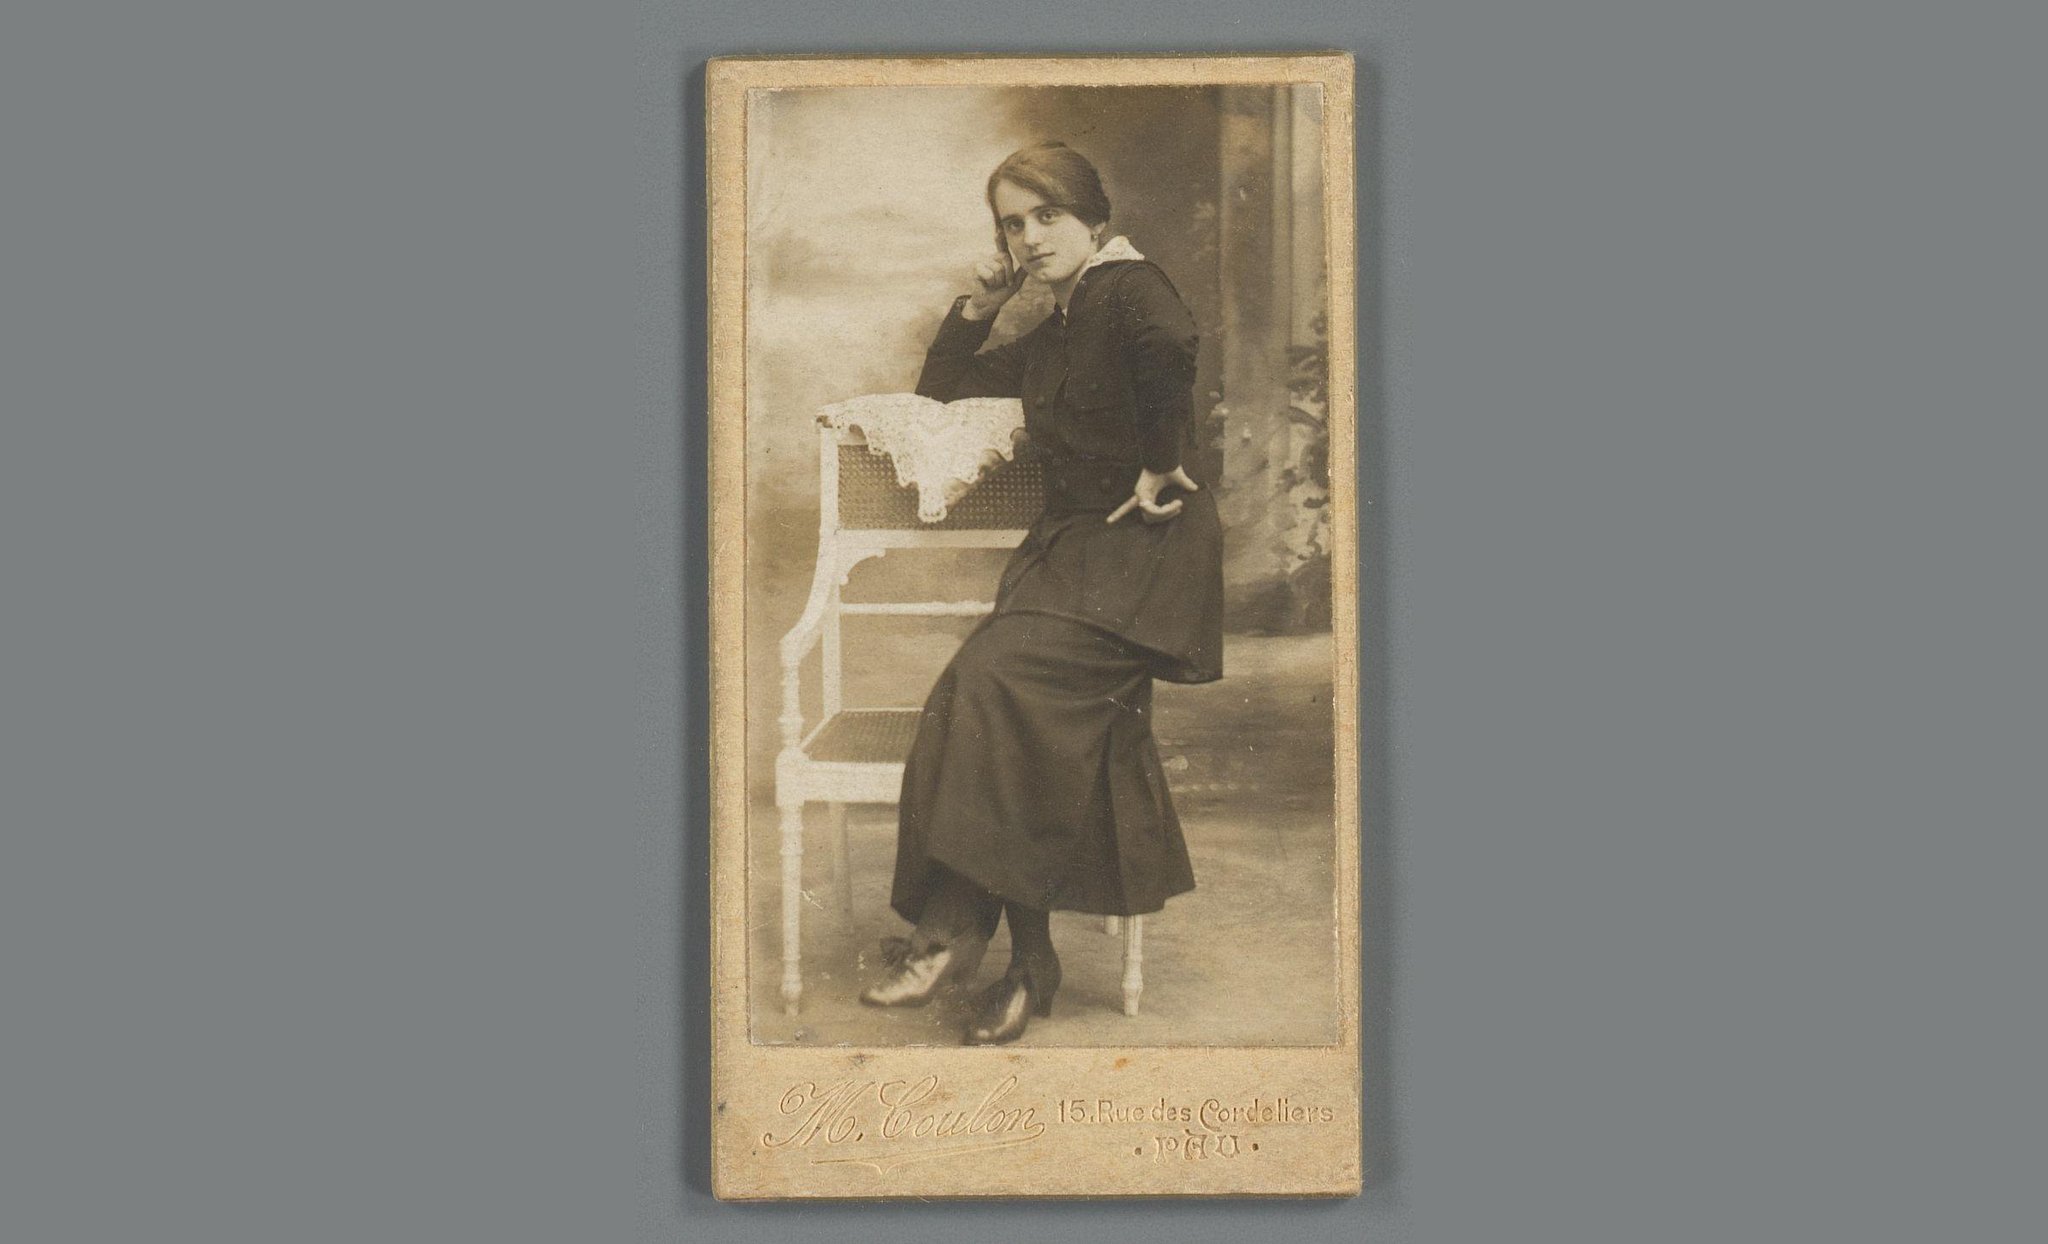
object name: photograph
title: Miniatuurportret van een onbekende jonge vrouw, zittend op de leuning van een stoel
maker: m. coulon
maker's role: fotograaf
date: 1900-1920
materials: paper, cardboard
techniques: gelatin silver print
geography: pau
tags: adolescent, young woman, maiden, historical persons not known by name - bb - woman, chair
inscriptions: inscription: ‘M. Coulon/ 15, Rue des Cordeliers/ Pau’